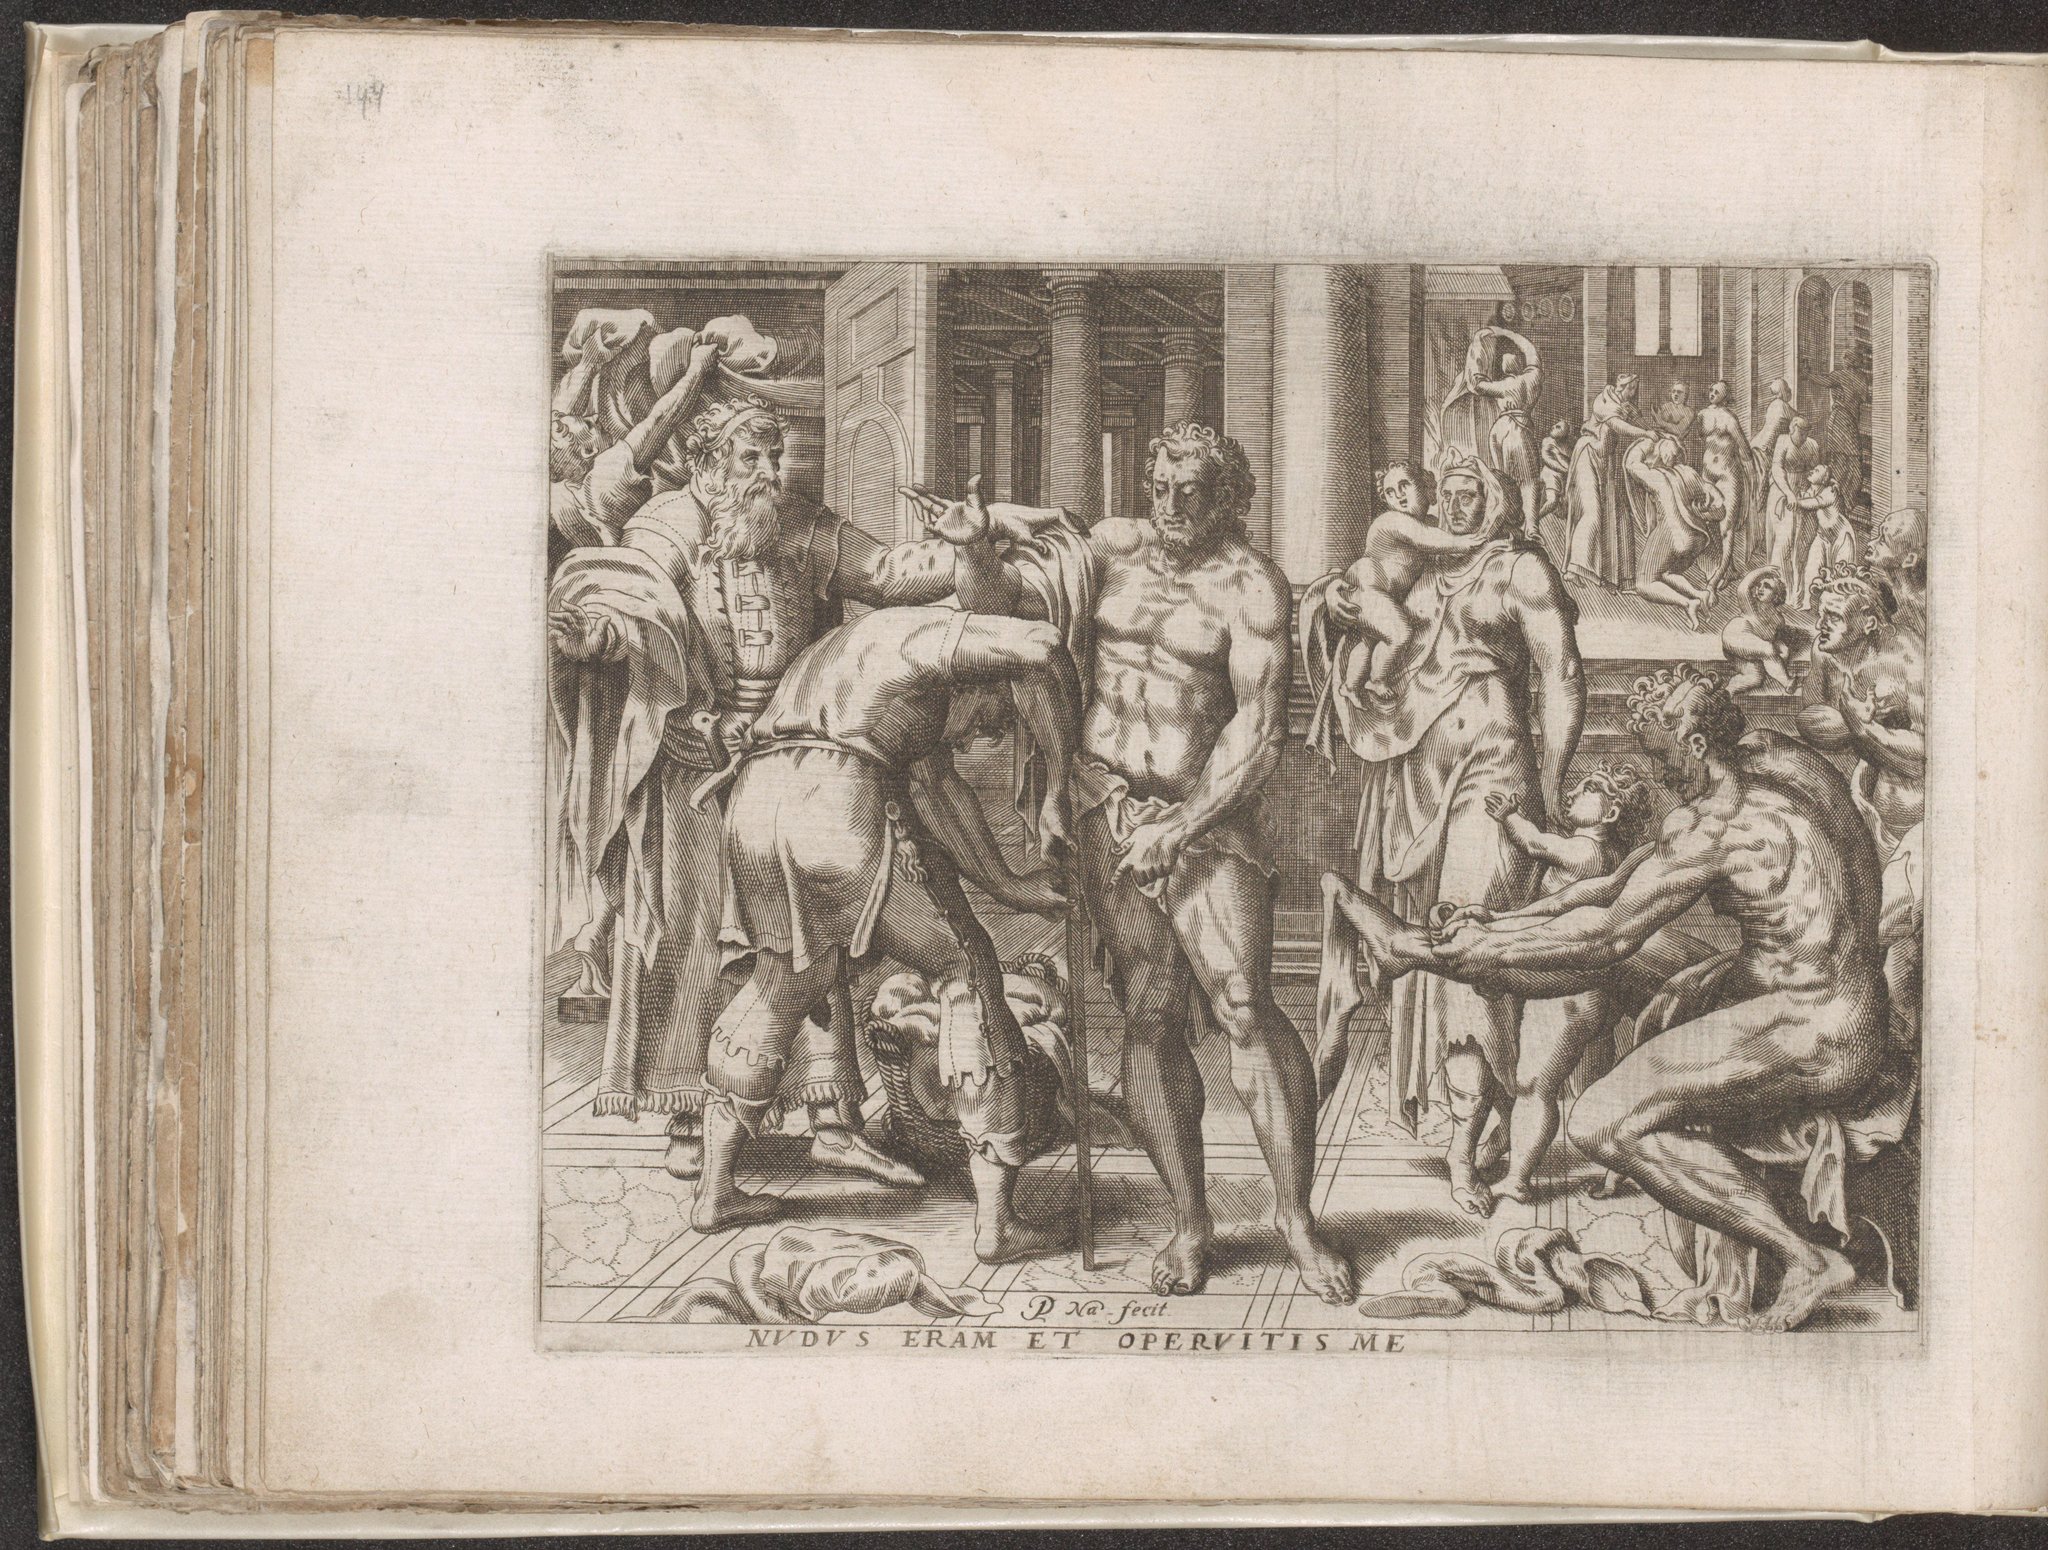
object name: print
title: Kleden van de naakten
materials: paper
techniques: engraving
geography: antwerp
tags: clothing the naked, 'nudus vestitur' ~ one of the (seven) acts of mercy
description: Een man neemt met een meetlat de maten van de middelste figuur. Links twee mannen, die stoffen aandragen. Rechts een zittende naakte man, die een kous aantrekt. Achter hem een vrouw met een kind op de arm. Op de achtergrond worden eveneens naakten gekleed. Onder de voorstelling een verklarende tekst in het Latijn. Deze prent maakt deel uit van een album.